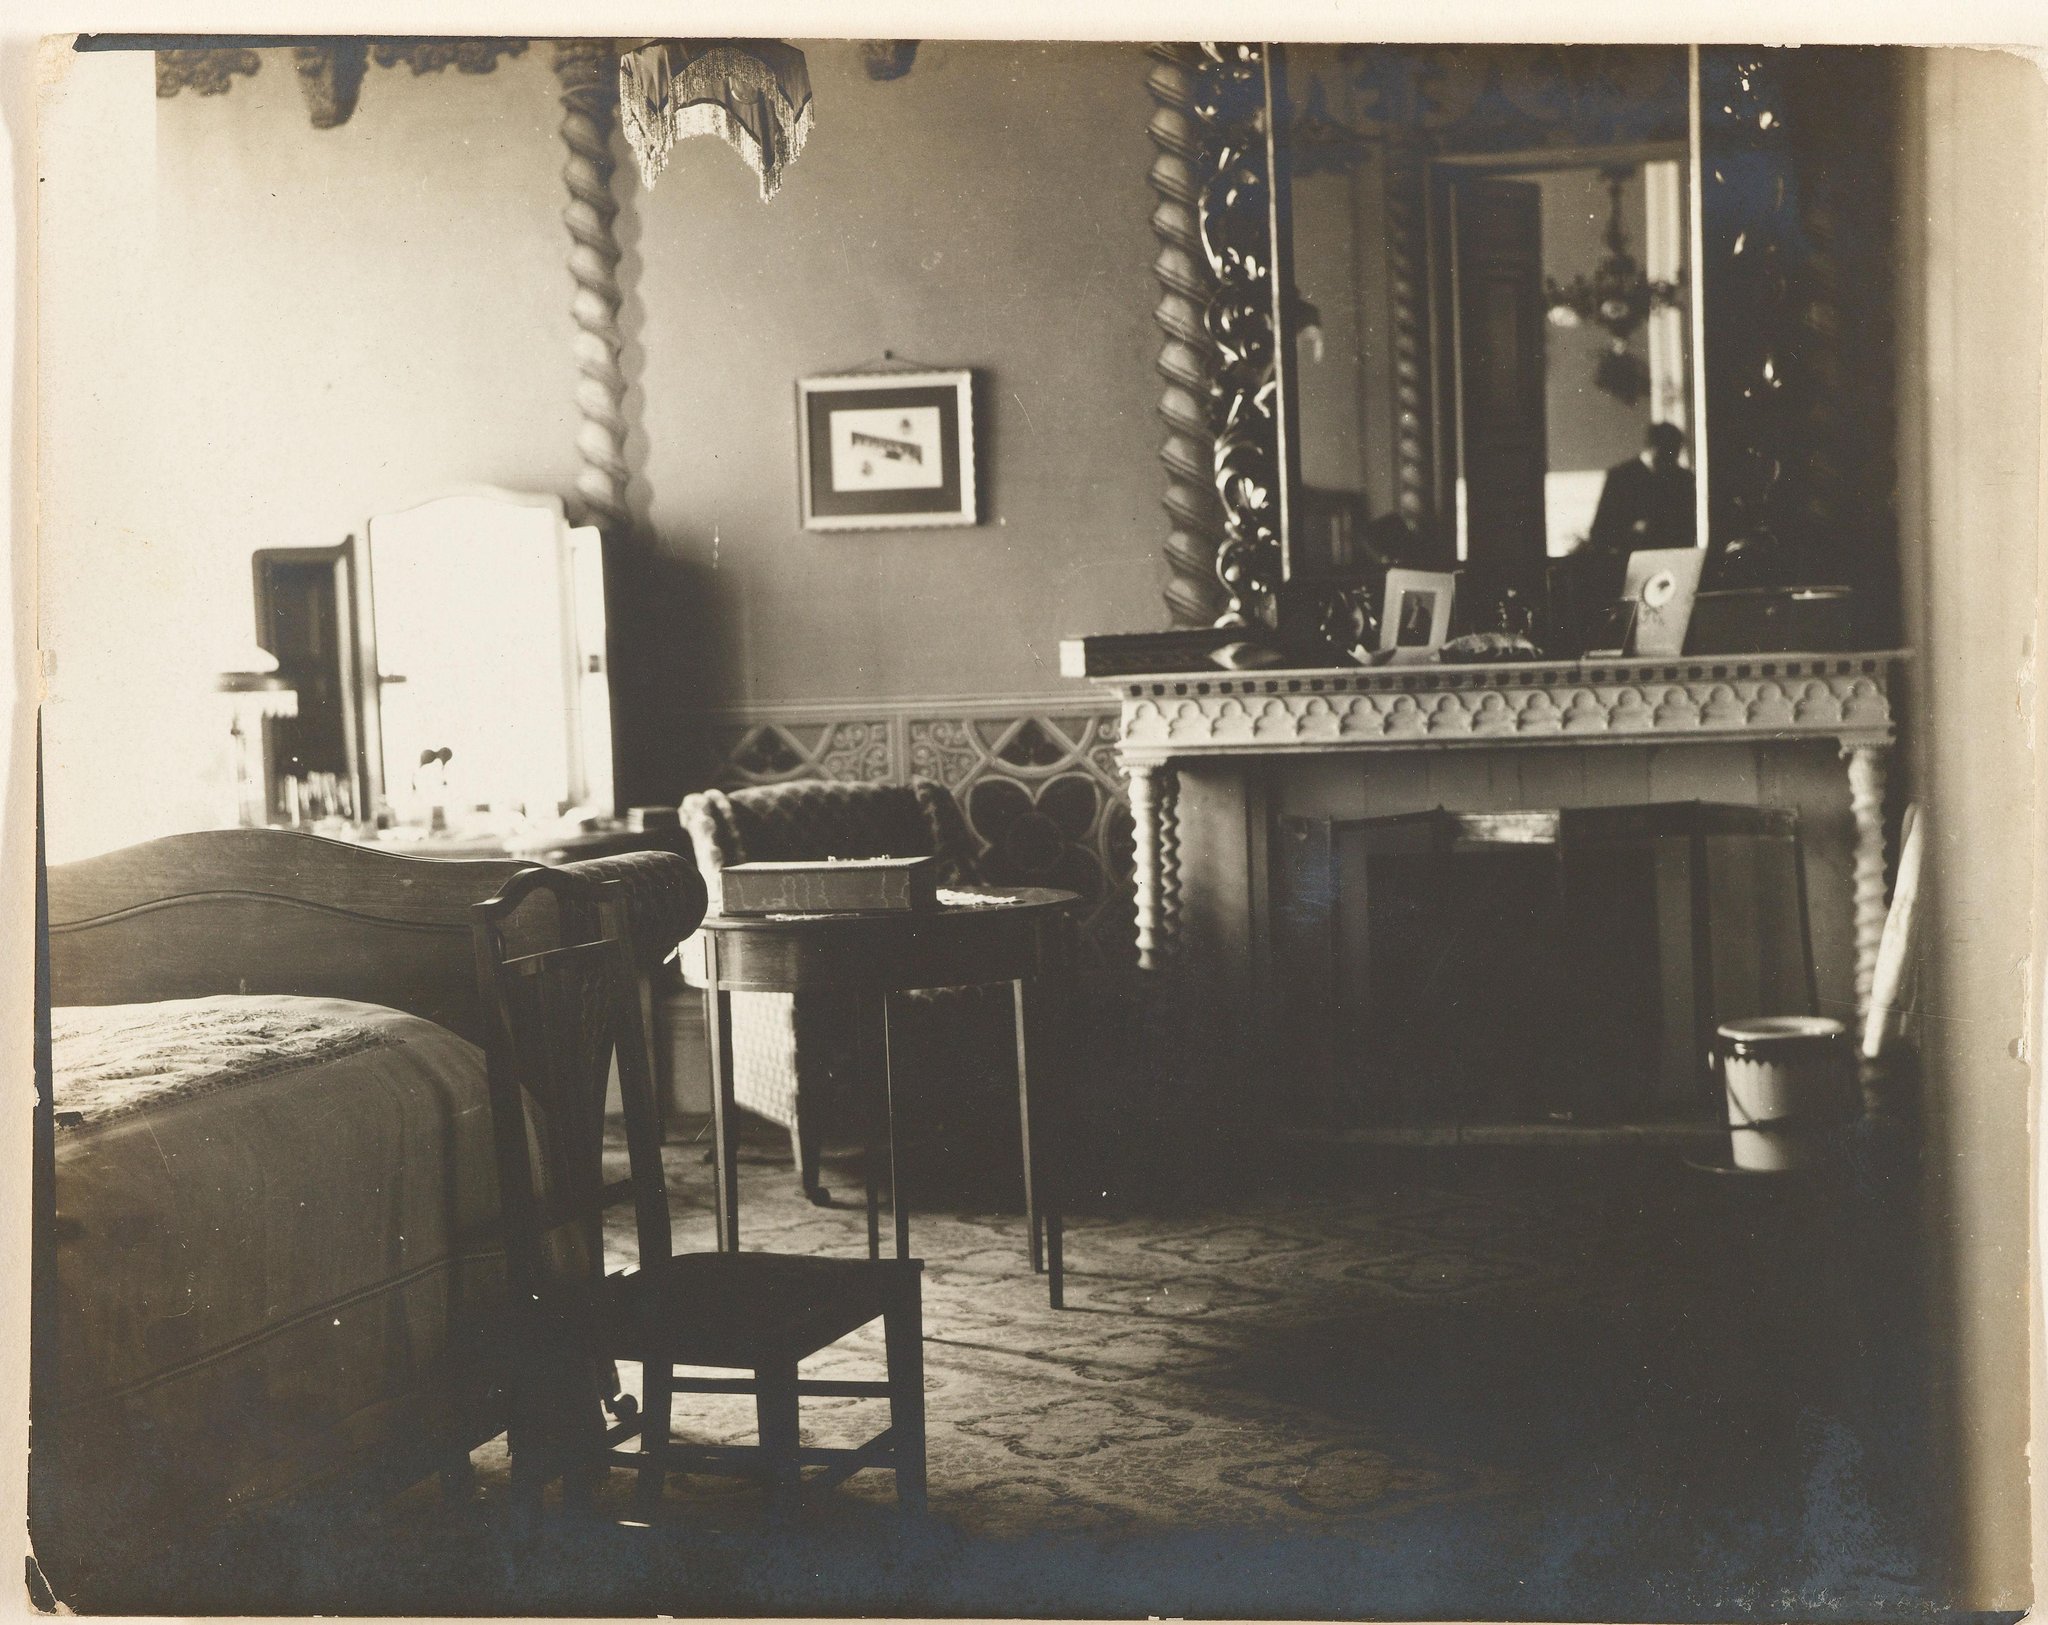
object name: photograph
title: Interieur van een slaapkamer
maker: Anonymous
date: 1918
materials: paper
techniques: gelatin silver print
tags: bedroom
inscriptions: inscription: ‘Unser Schlafzimmer’